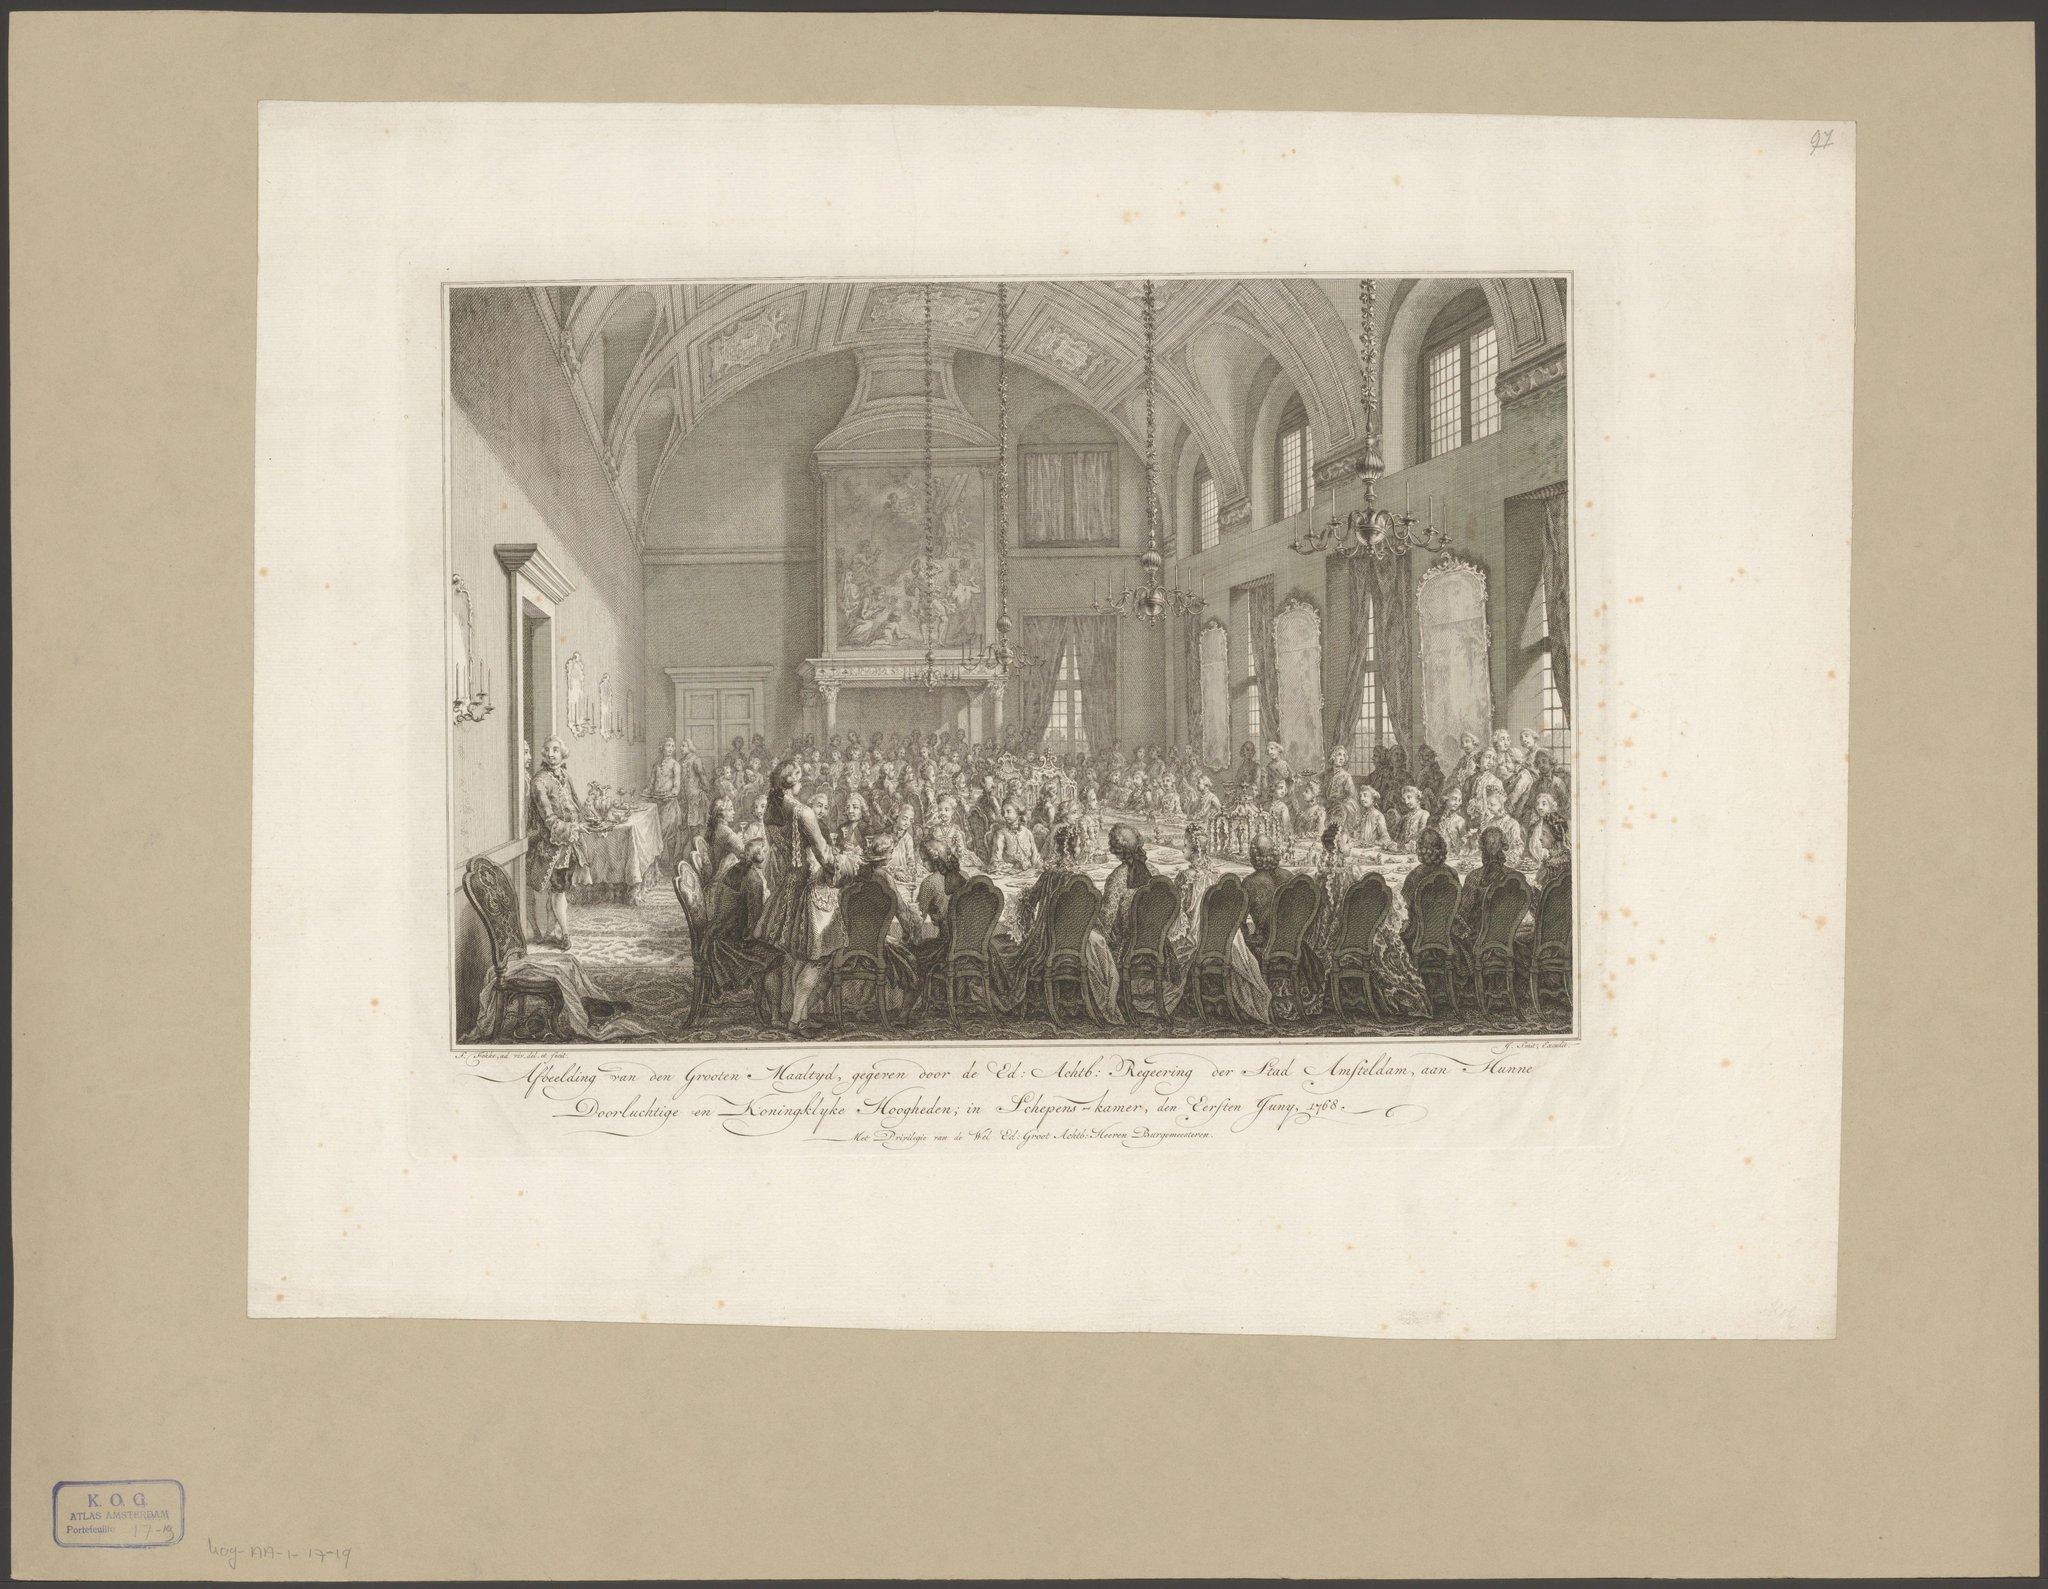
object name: print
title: Afbeelding der Vreugdebedryven en Plegtigheden die by de aankomst en gedurende het verblyf (...) Willem (...) en zyne Gemaalinne (...) zyn voorgevallen te Amsterdam, op maandag, den 30 Mey, en eenige volgende dagen, des jaars 1768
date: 1773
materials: paper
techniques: engraving, etching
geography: amsterdam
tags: the hague, william v (prince of orange), berlin, painter, draughtsman, wilhelmina of prussia (princess of orange), public festivities on the occasion of royal events (+ eating and drinking ~ festive activities), townhall, celebration meal, feast, banquet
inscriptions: collector's mark: ‘17.19’ Lugt 1641b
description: Onderwerpsrubriek binnen de Atlas Amsterdam: Nieuwe Stadhuis, van binnen: Groote zaal, Raadkamer, Schepenkamer, Troonzaal, Mozeszaal, Zitkamer.